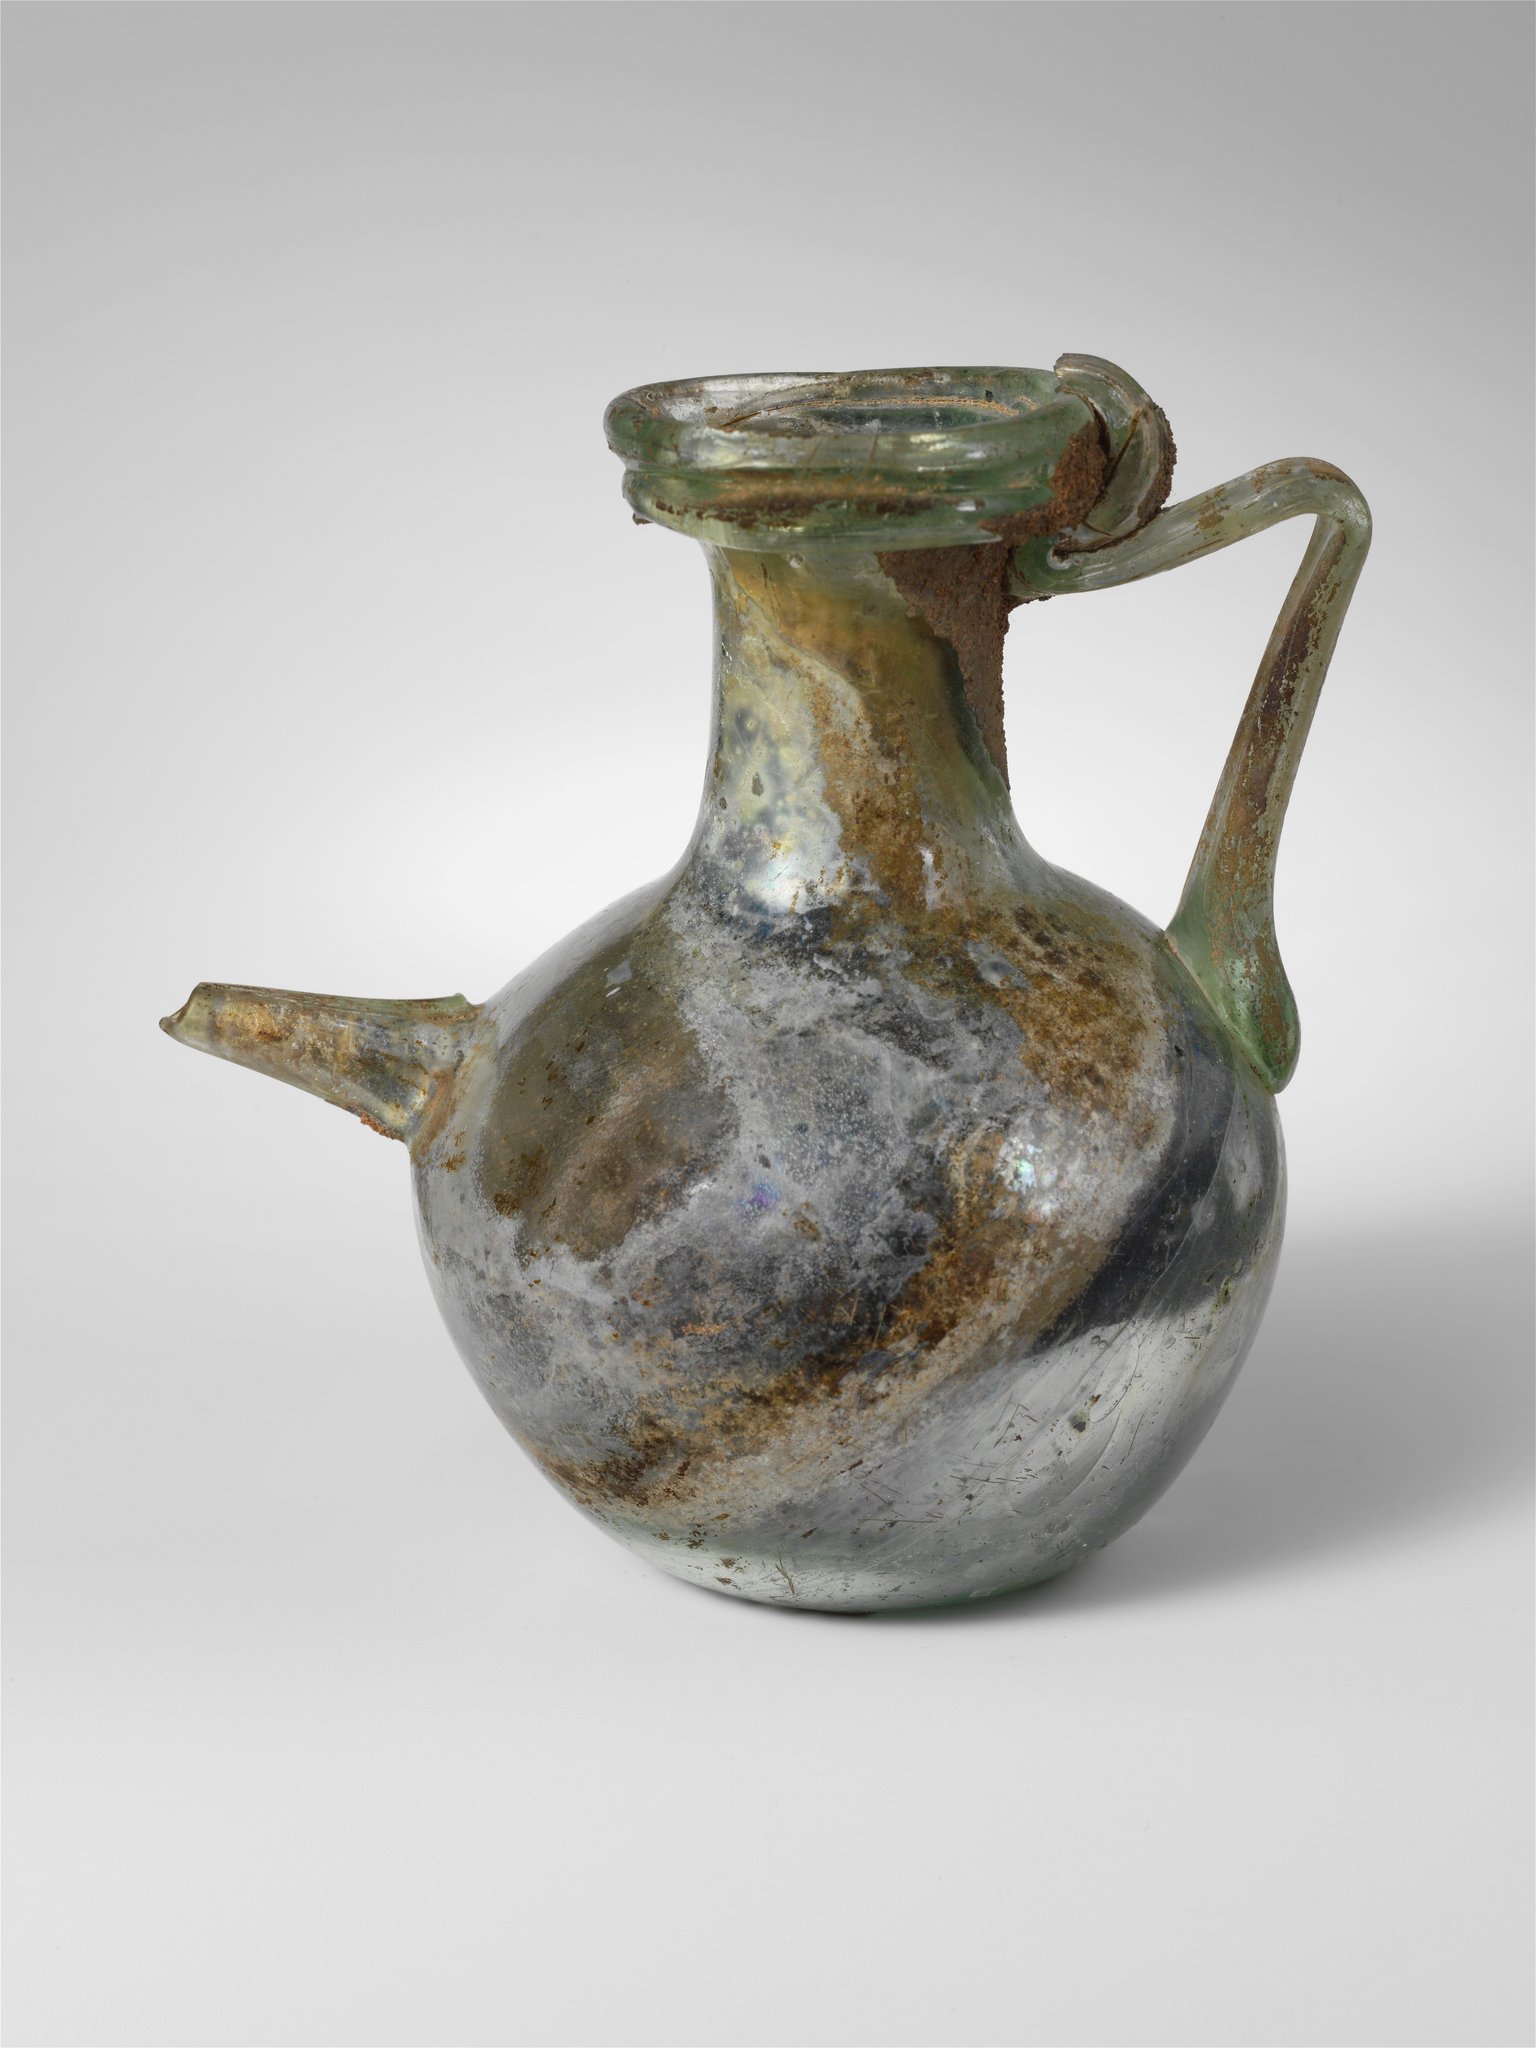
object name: pourer jug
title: Glass spouted bottle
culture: roman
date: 167-400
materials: glass